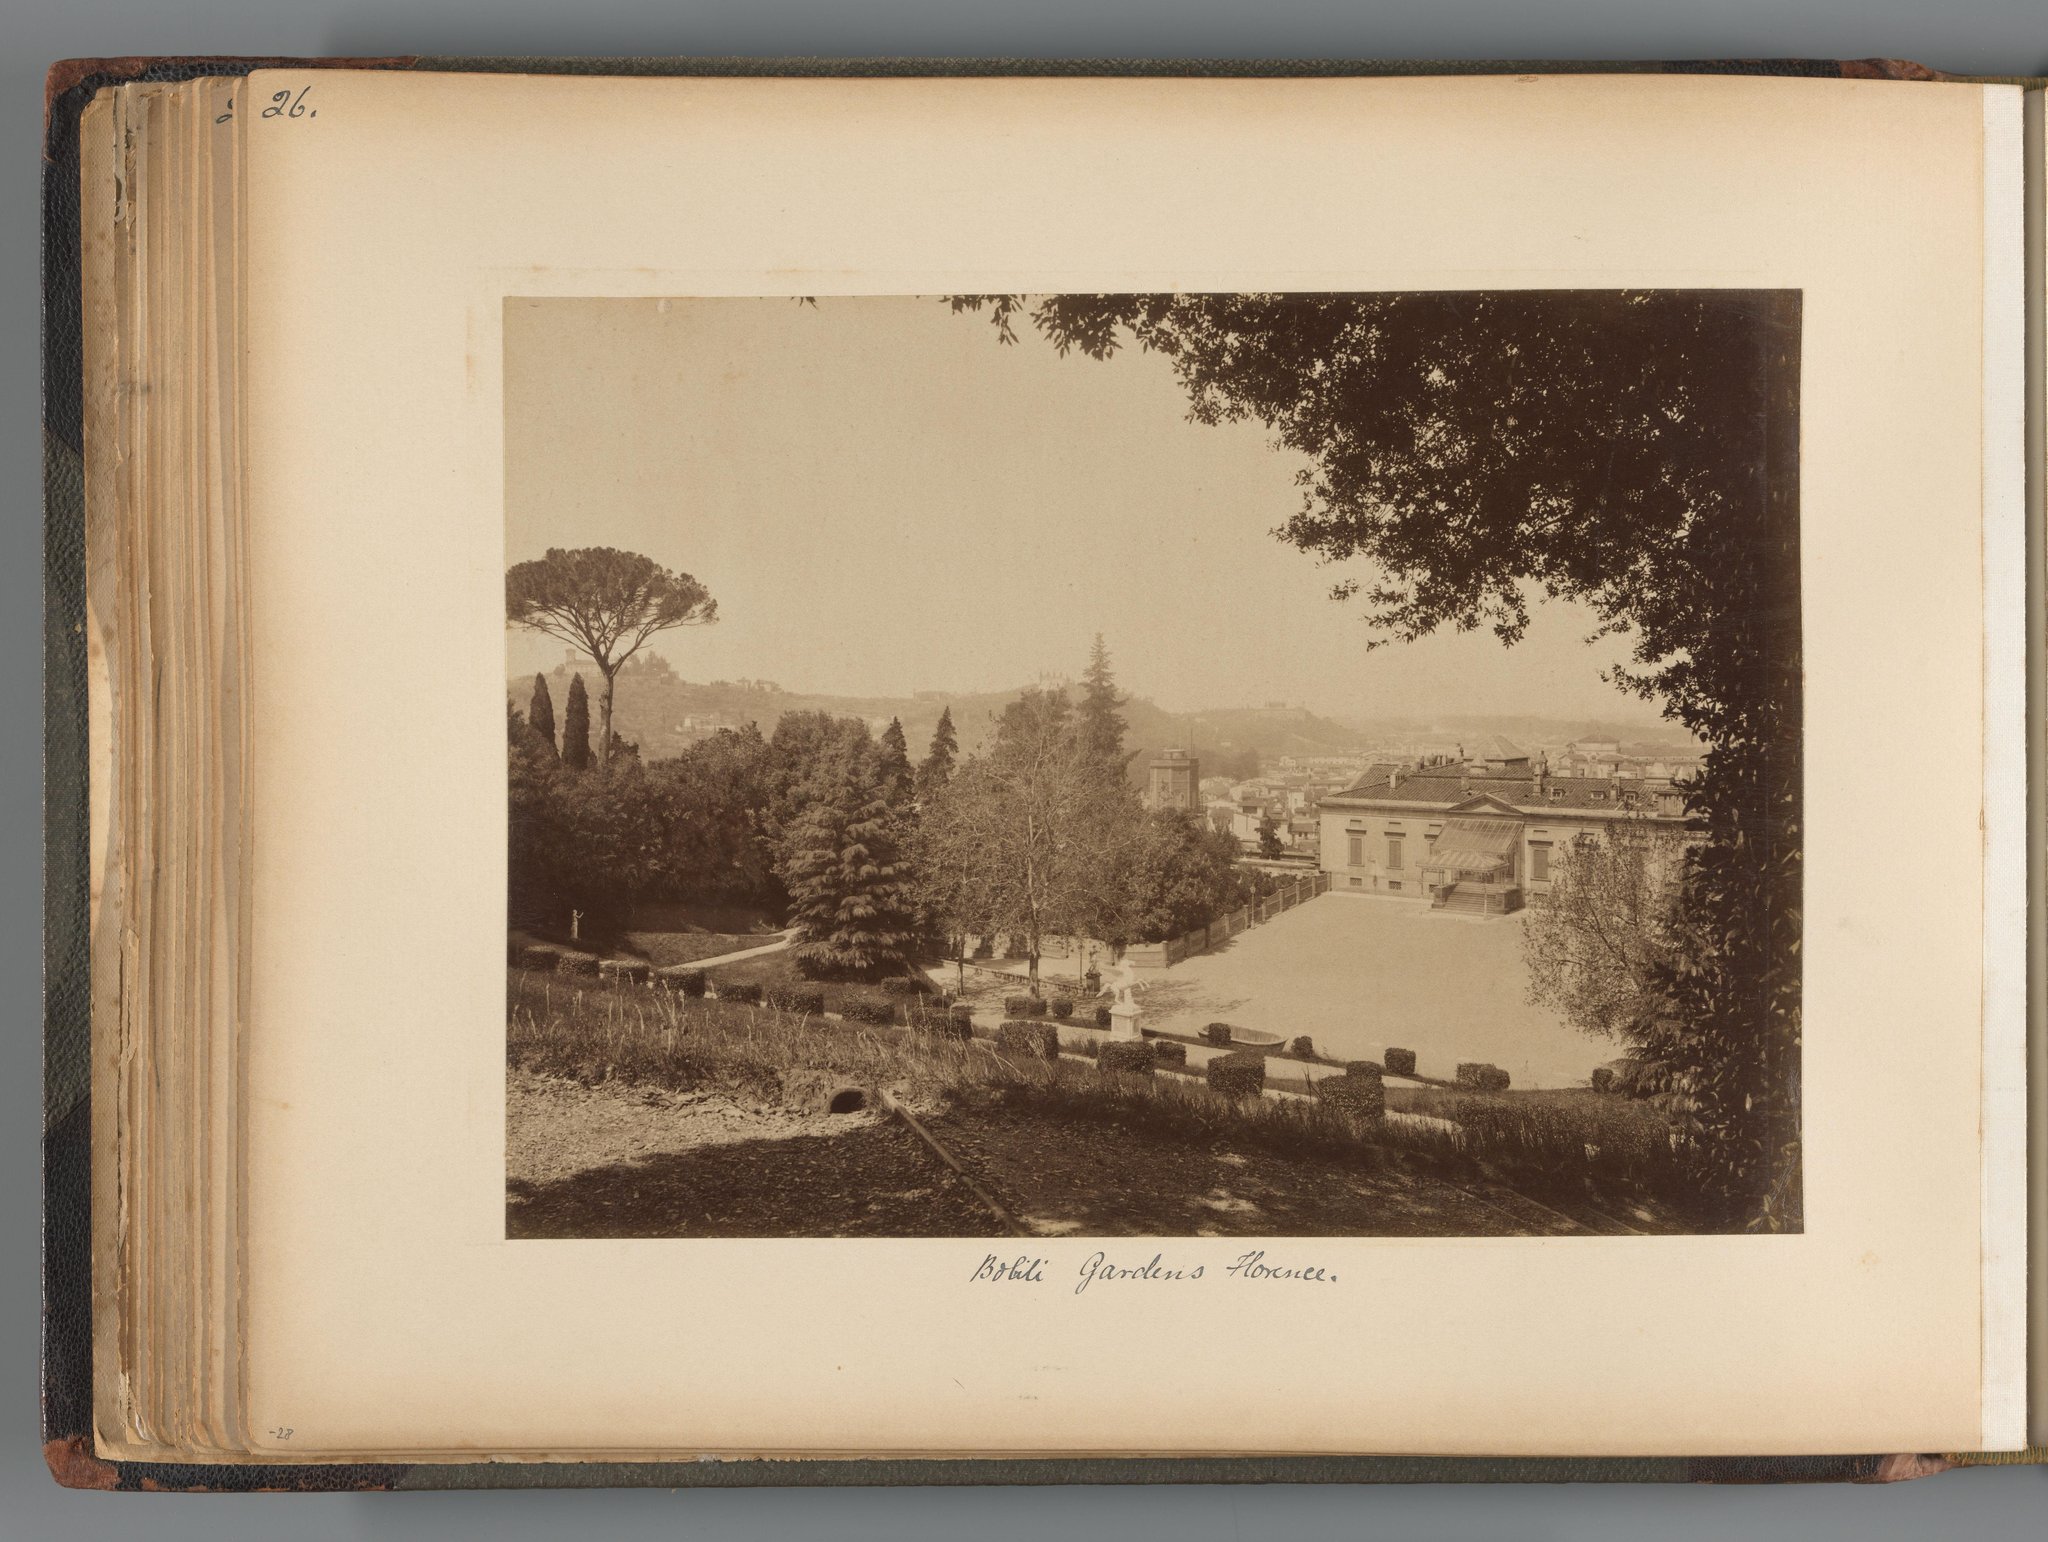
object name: photograph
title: Bobili gardens, Florence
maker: c.c. blackburn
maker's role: fotograaf, luitenant-kolonel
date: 1877-1892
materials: paper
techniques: albumen print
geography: florence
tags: garden